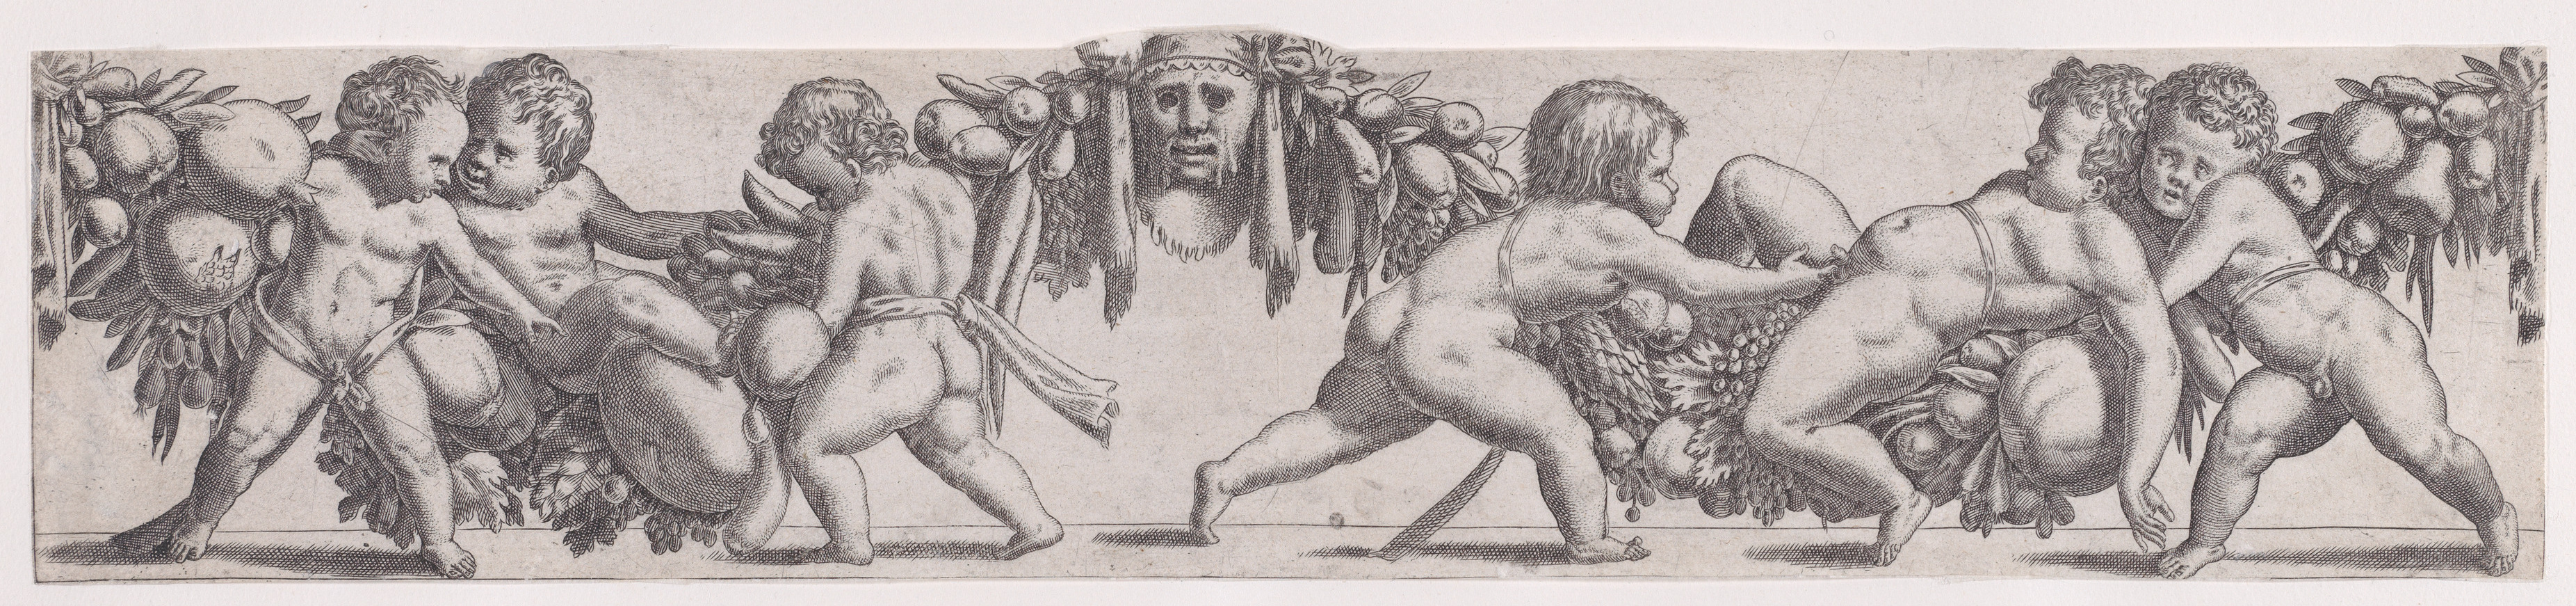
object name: print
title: Two Groups of Three Putti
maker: anonymous, french, school of fontainebleau, 16th century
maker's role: artist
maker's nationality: french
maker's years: 1500-1600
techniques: engraving